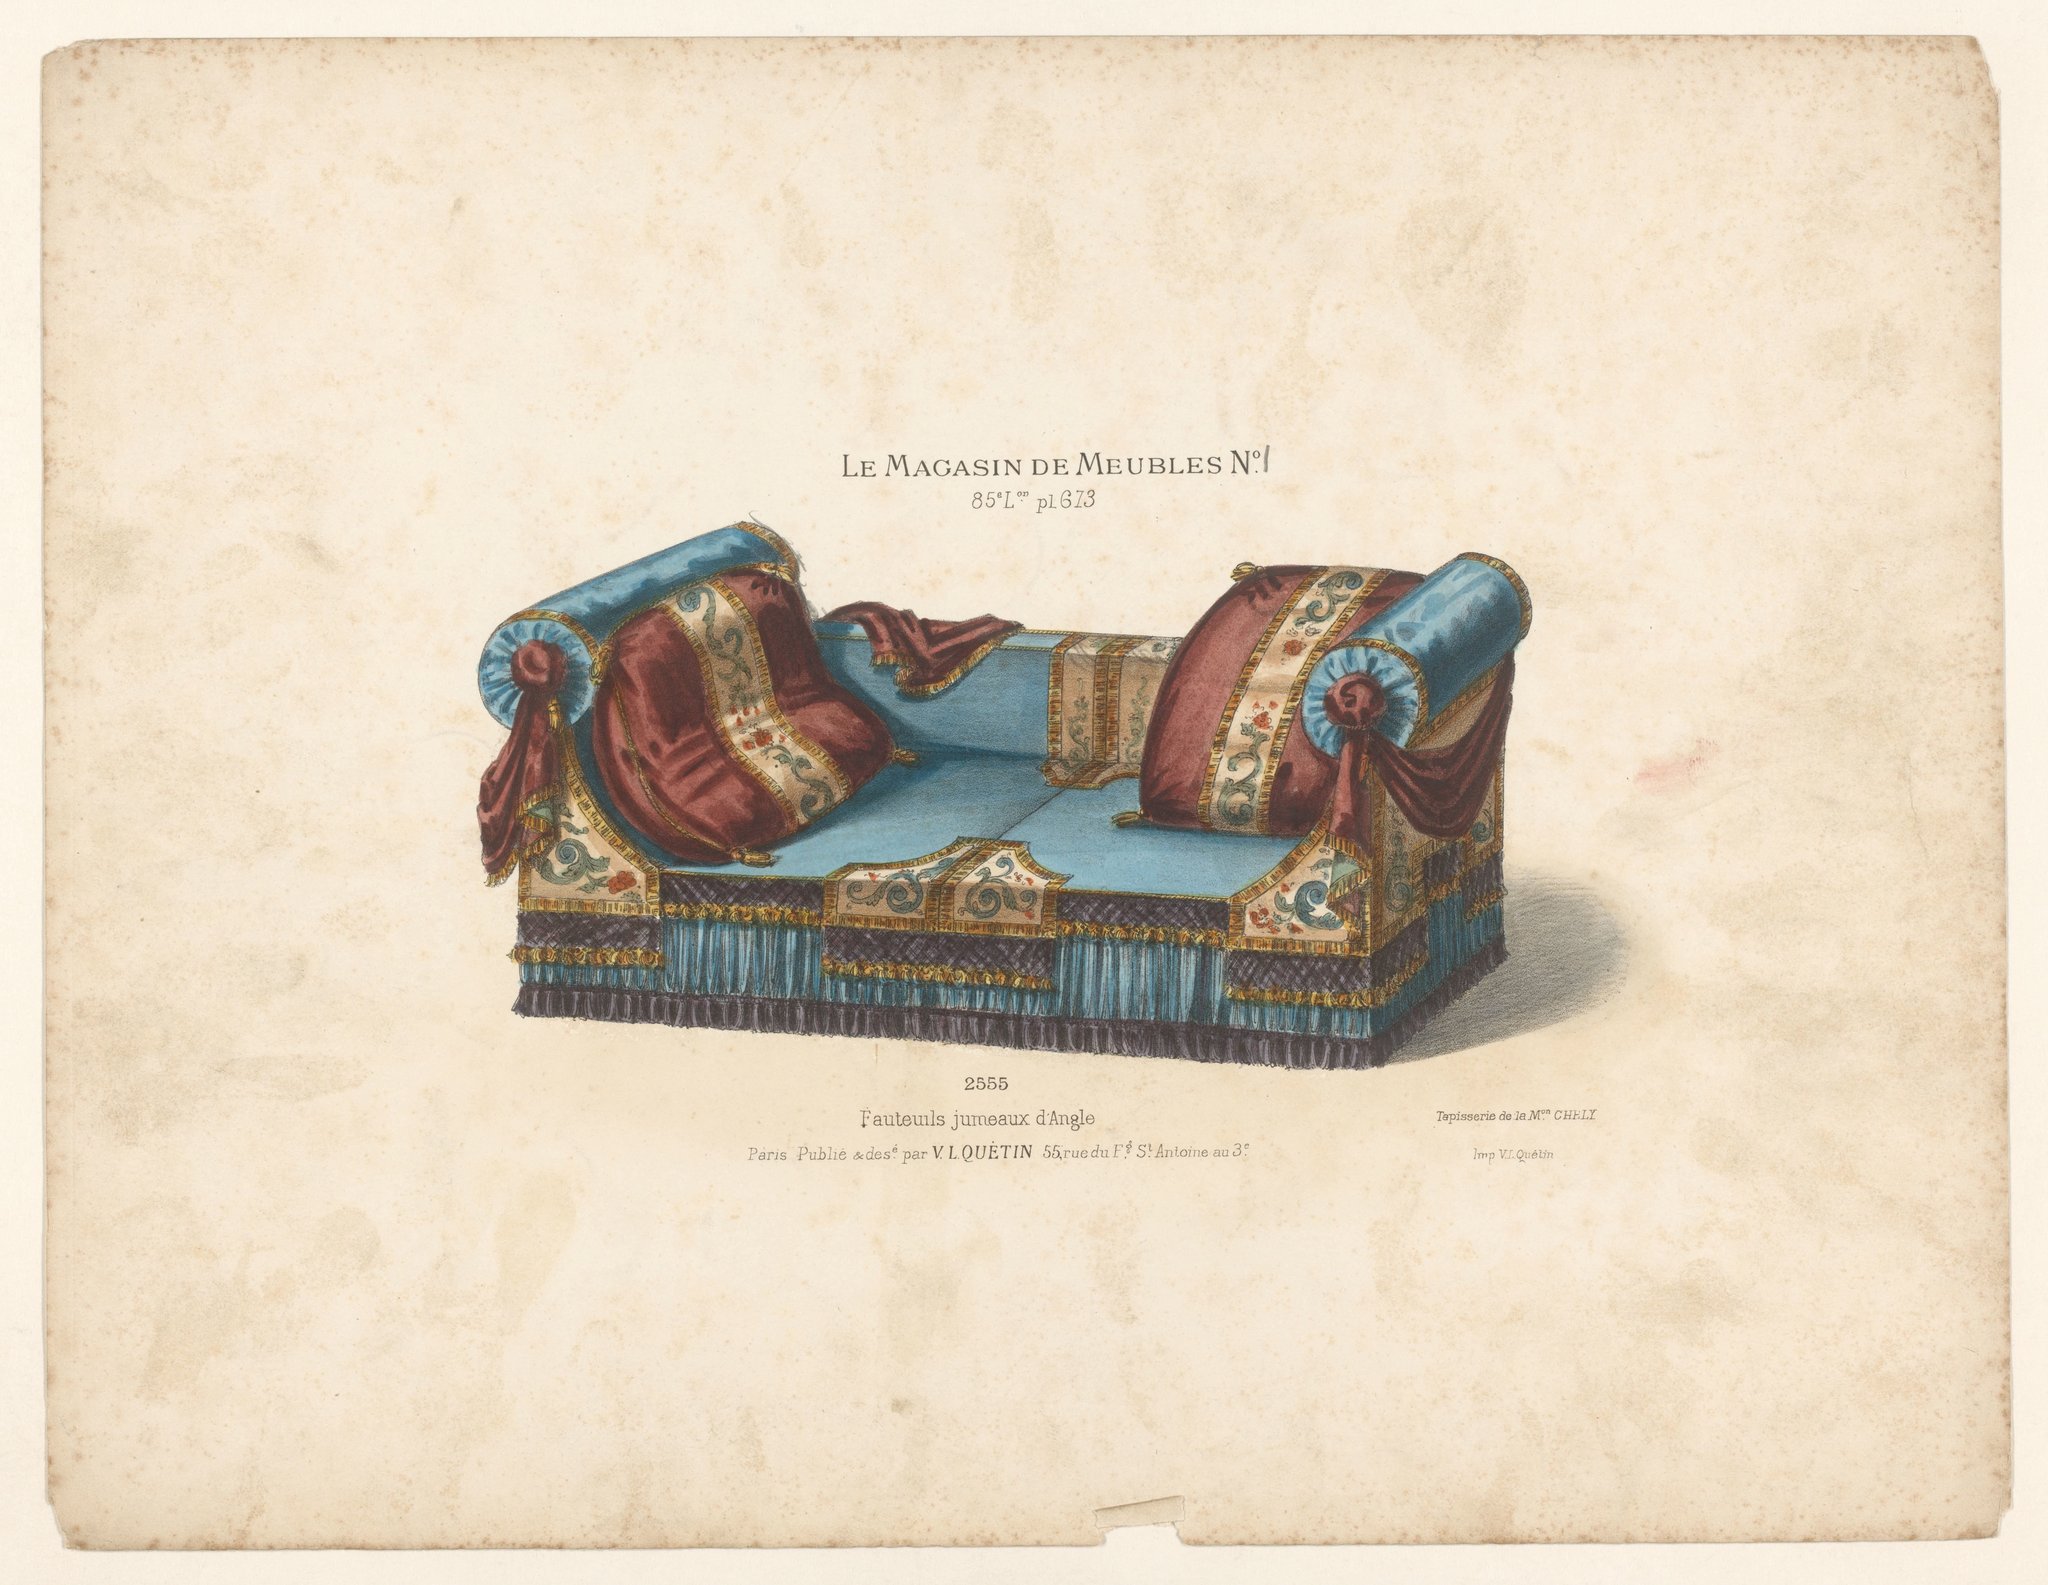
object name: print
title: Le Magasin de Meubles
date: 1878-1904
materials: paper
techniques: hand coloring, lithograph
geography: paris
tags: seating furniture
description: Twee fauteuils die elkaar spiegelen en samen een bank vormen. Prent uit 85e Livraison.